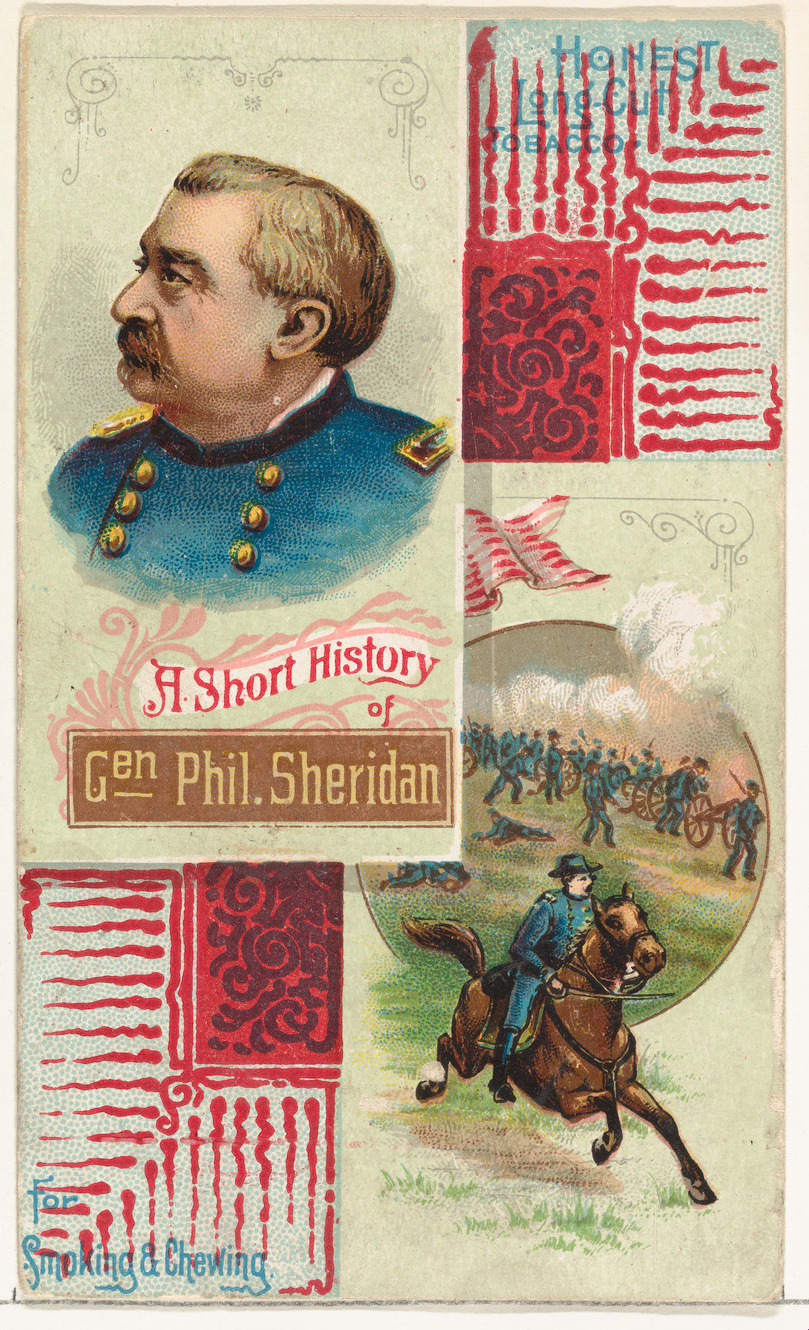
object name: print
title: A Short History: General Philip H. Sheridan, from the Histories of Generals series (N114) issued by W. Duke, Sons & Co. to promote Honest Long Cut Smoking and Chewing Tobacco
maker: w. duke, sons & co.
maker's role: publisher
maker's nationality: american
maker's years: 1870-1920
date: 1888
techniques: color lithograph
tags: men,profiles,horses,generals